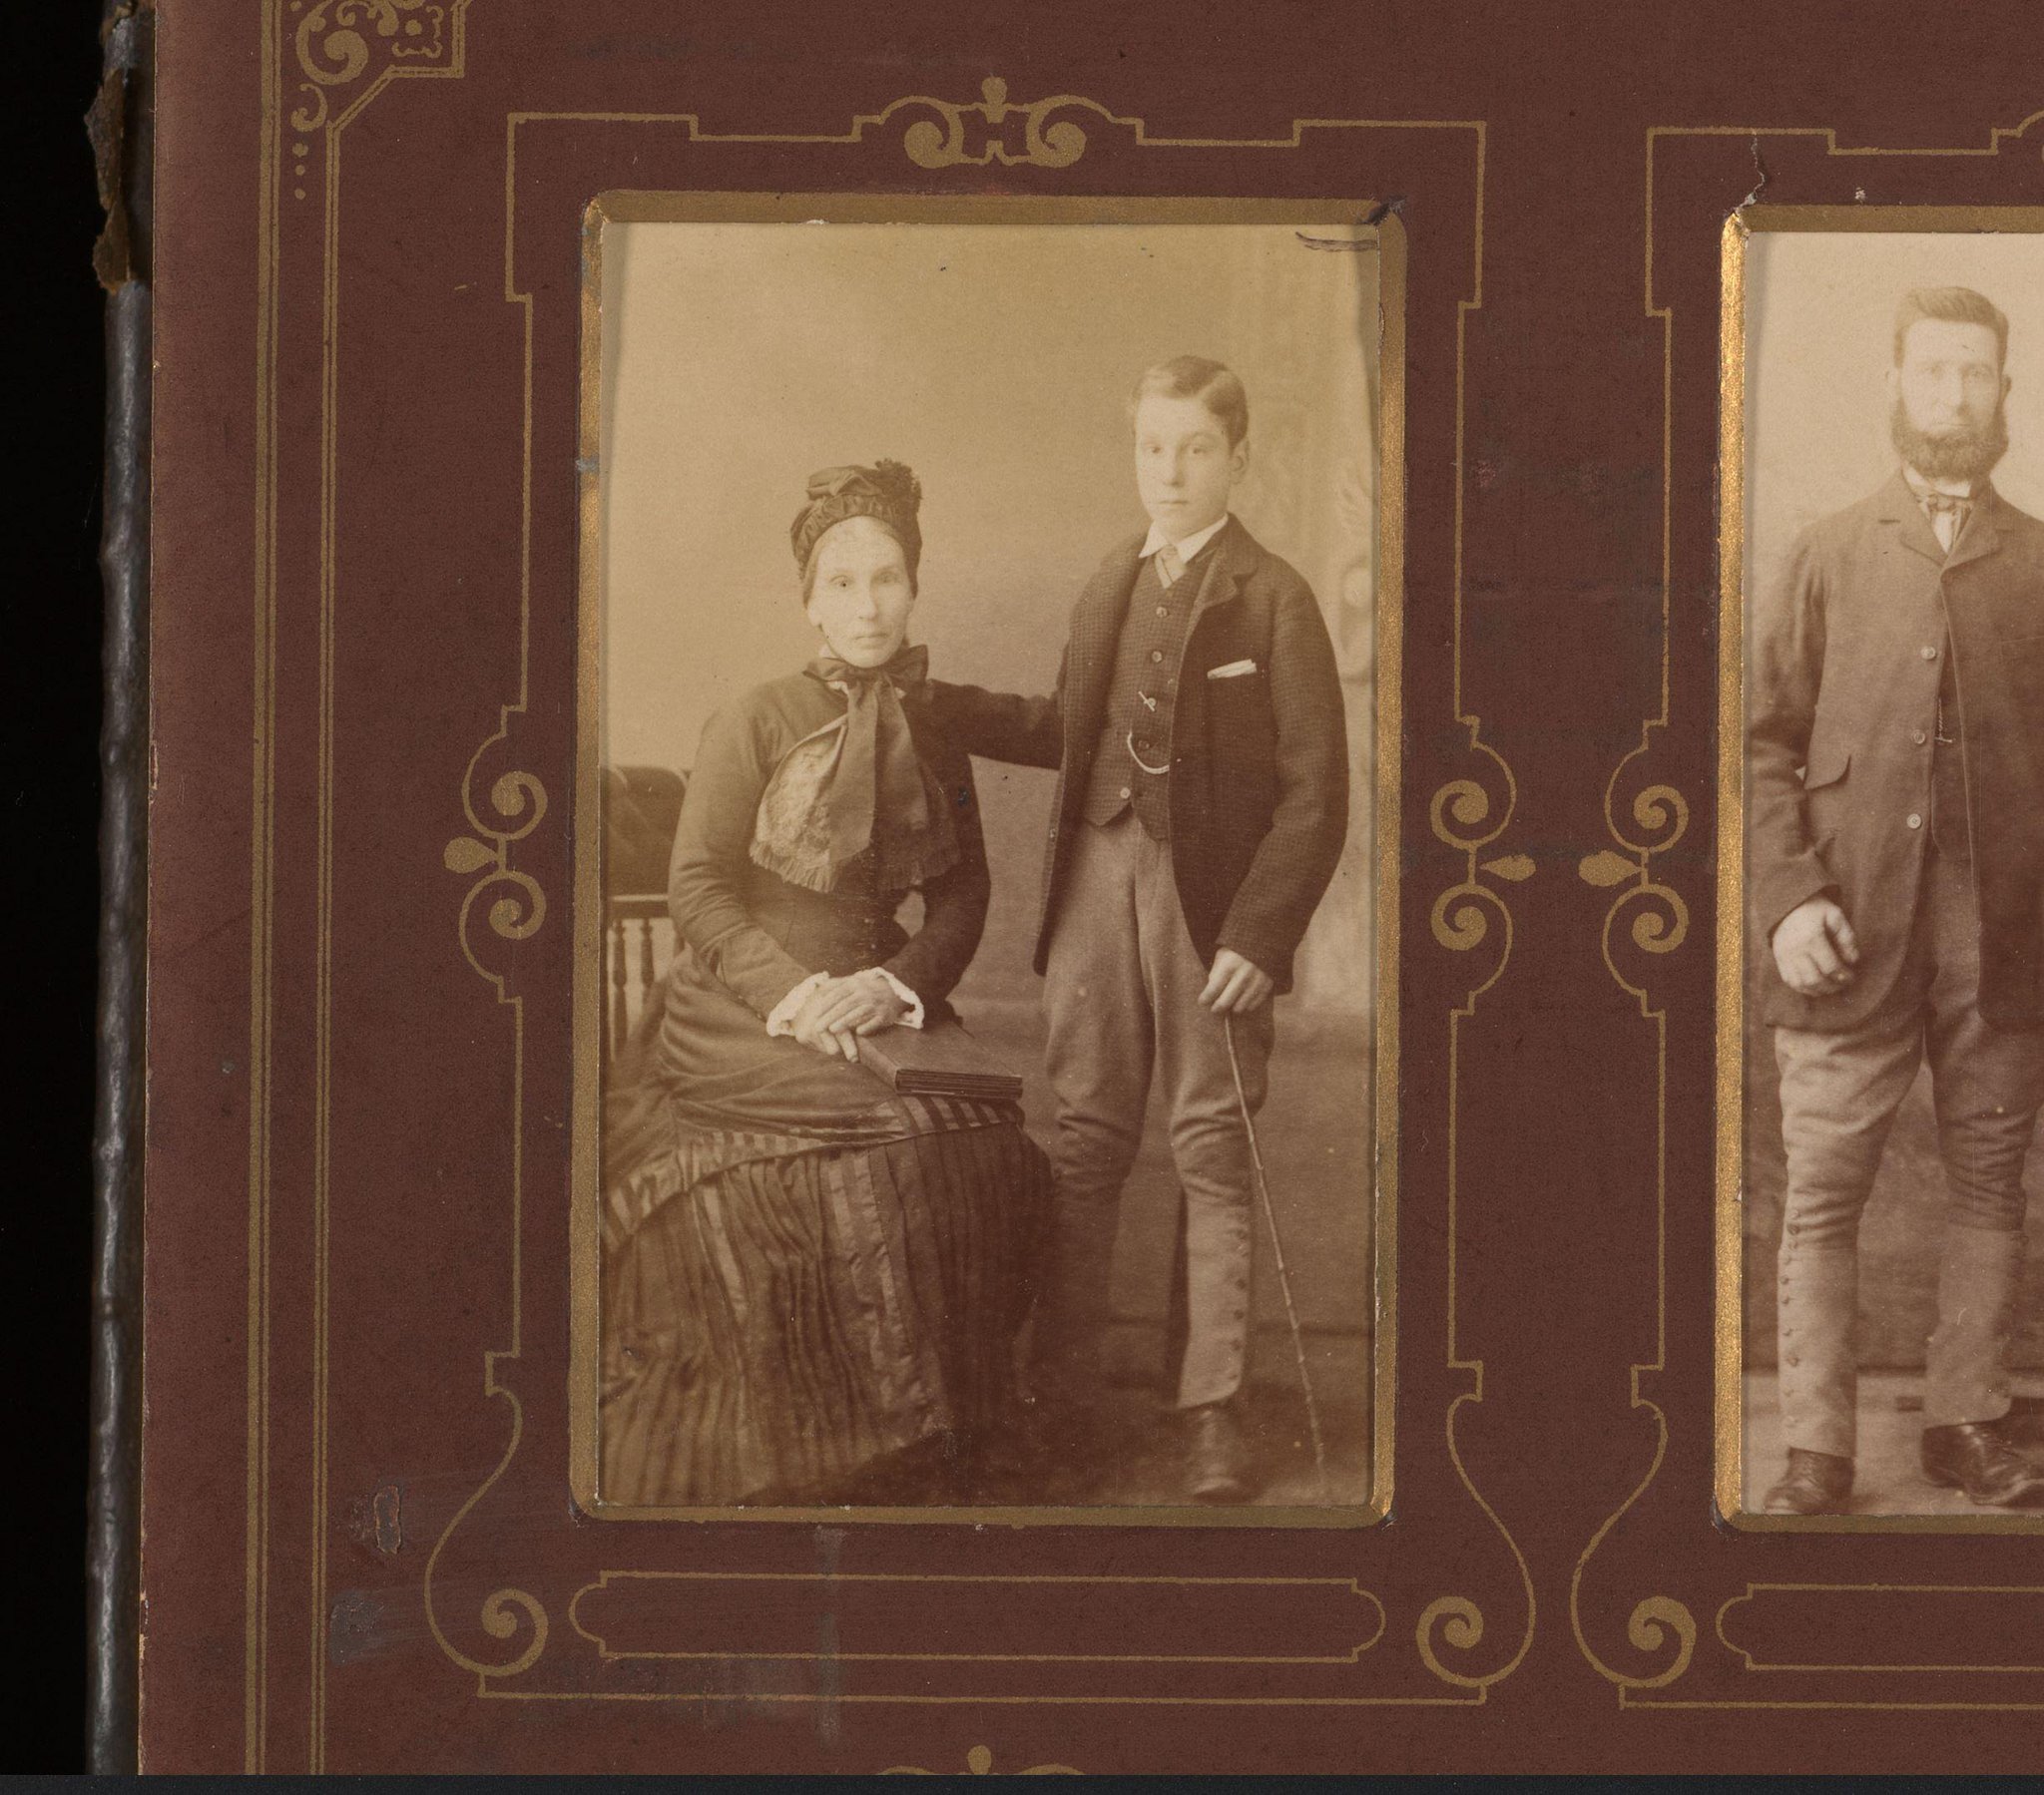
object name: album leaf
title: Portret van een zittende moeder met zoon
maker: henry robert sherborn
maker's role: fotograaf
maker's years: 1846-1899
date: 1870-1899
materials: cardboard, photographic support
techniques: albumen print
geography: england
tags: mother and son(s) (family group), historical persons - bb - woman, boy (child between toddler and youth)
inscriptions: inscription: ‘H.R. Sherborn/ Photographer/ High St./ Newmarket’